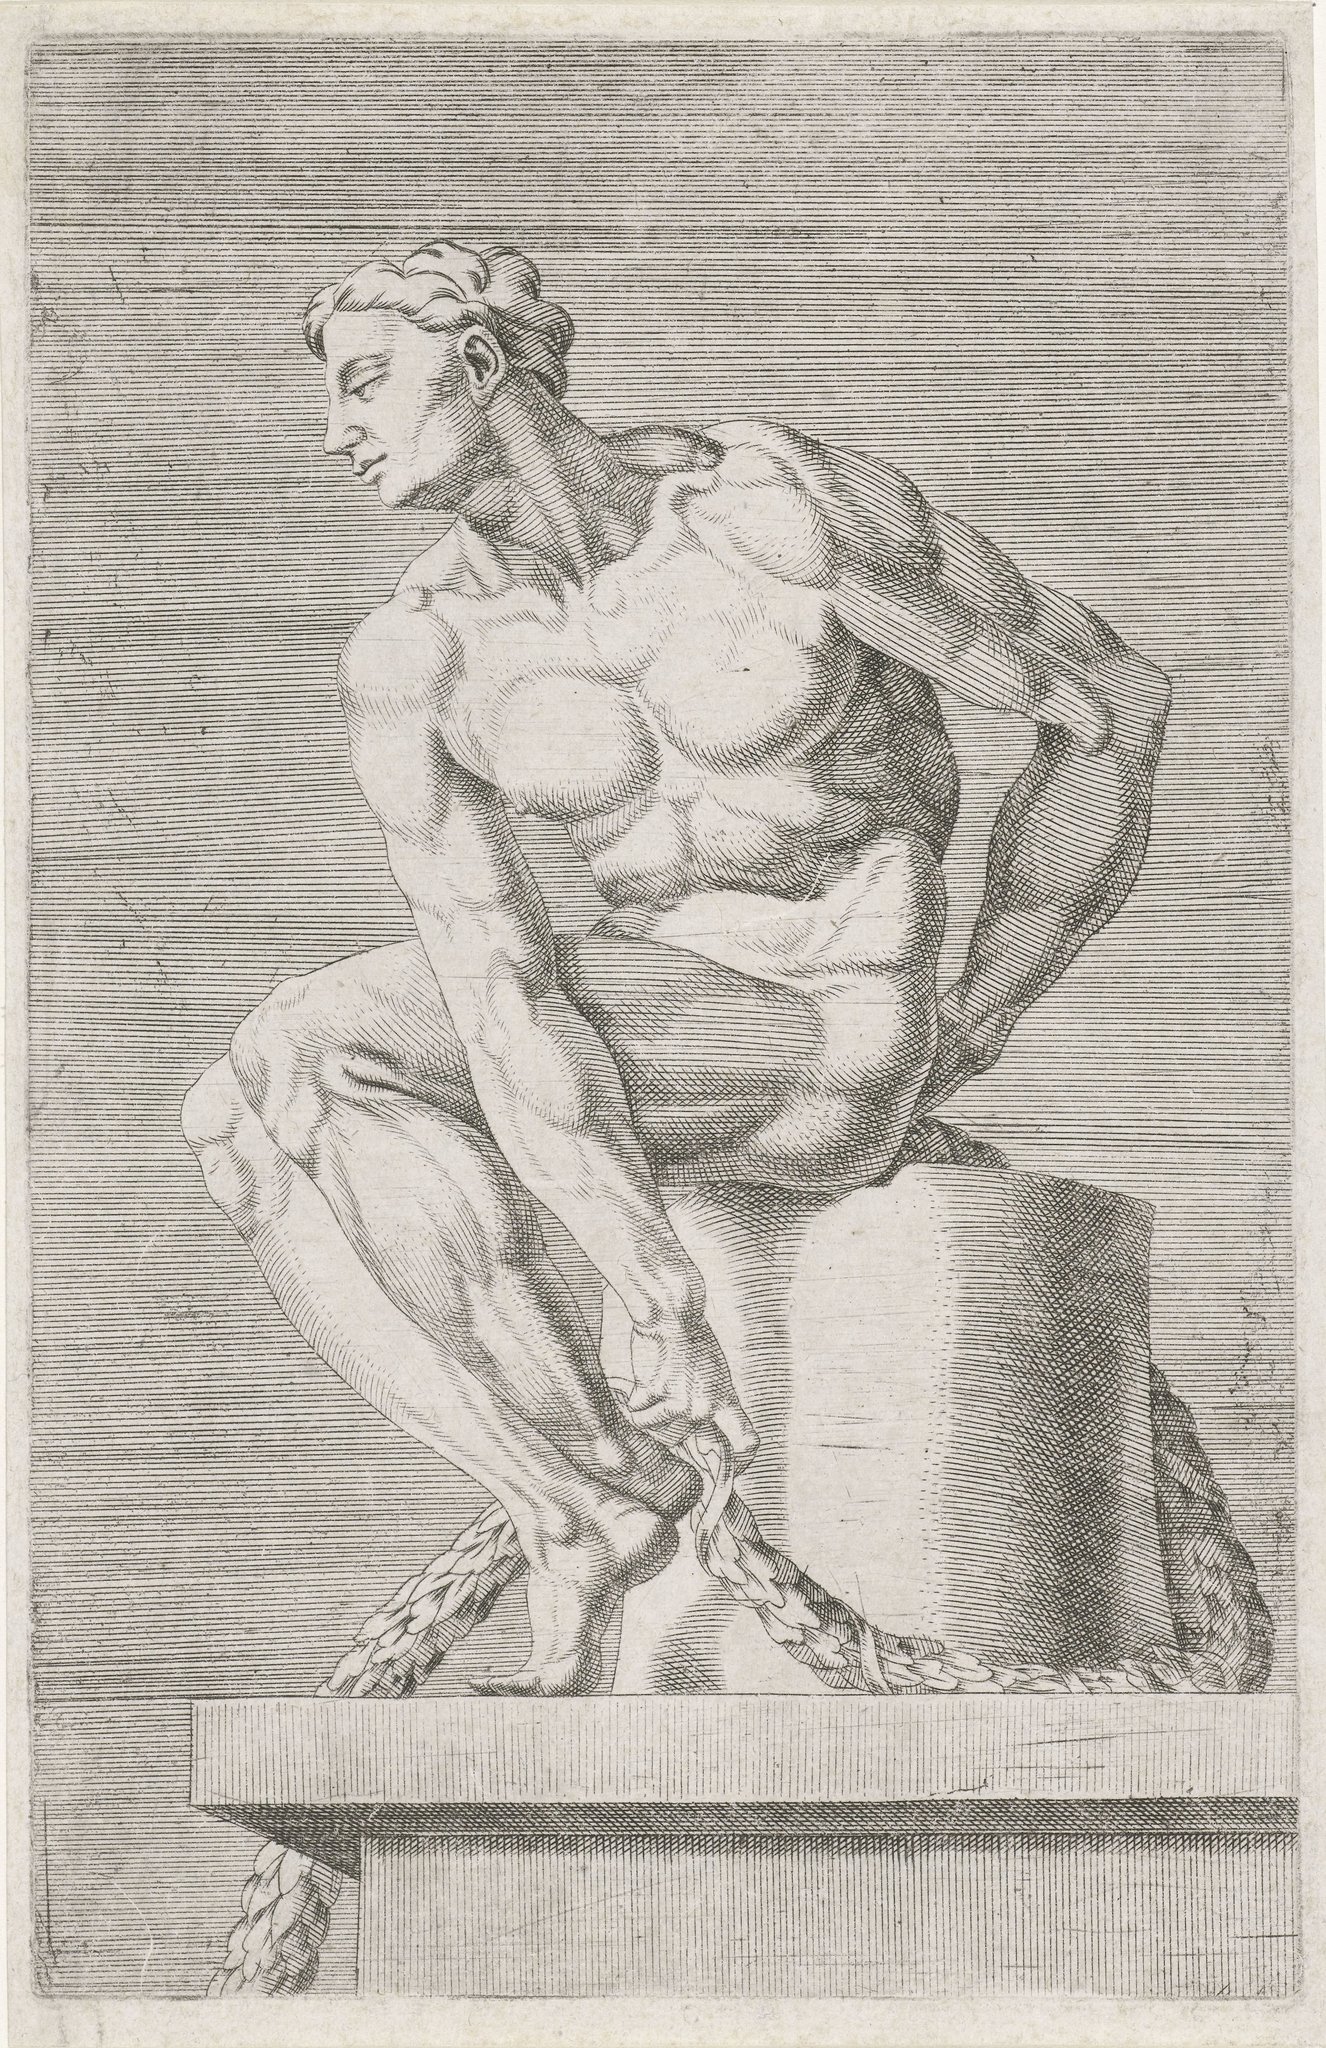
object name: print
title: Zittend naakt uit de Sixtijnse kapel.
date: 1551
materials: paper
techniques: engraving, etching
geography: rome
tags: the (nude) human figure; 'corpo humano' (ripa)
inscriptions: collector's mark: Lugt 2228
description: Zittende naakte jongeman, in profiel naar links. Uit serie van 20 prenten met Michelangelo's naakten in de Sixtijnse kapel.